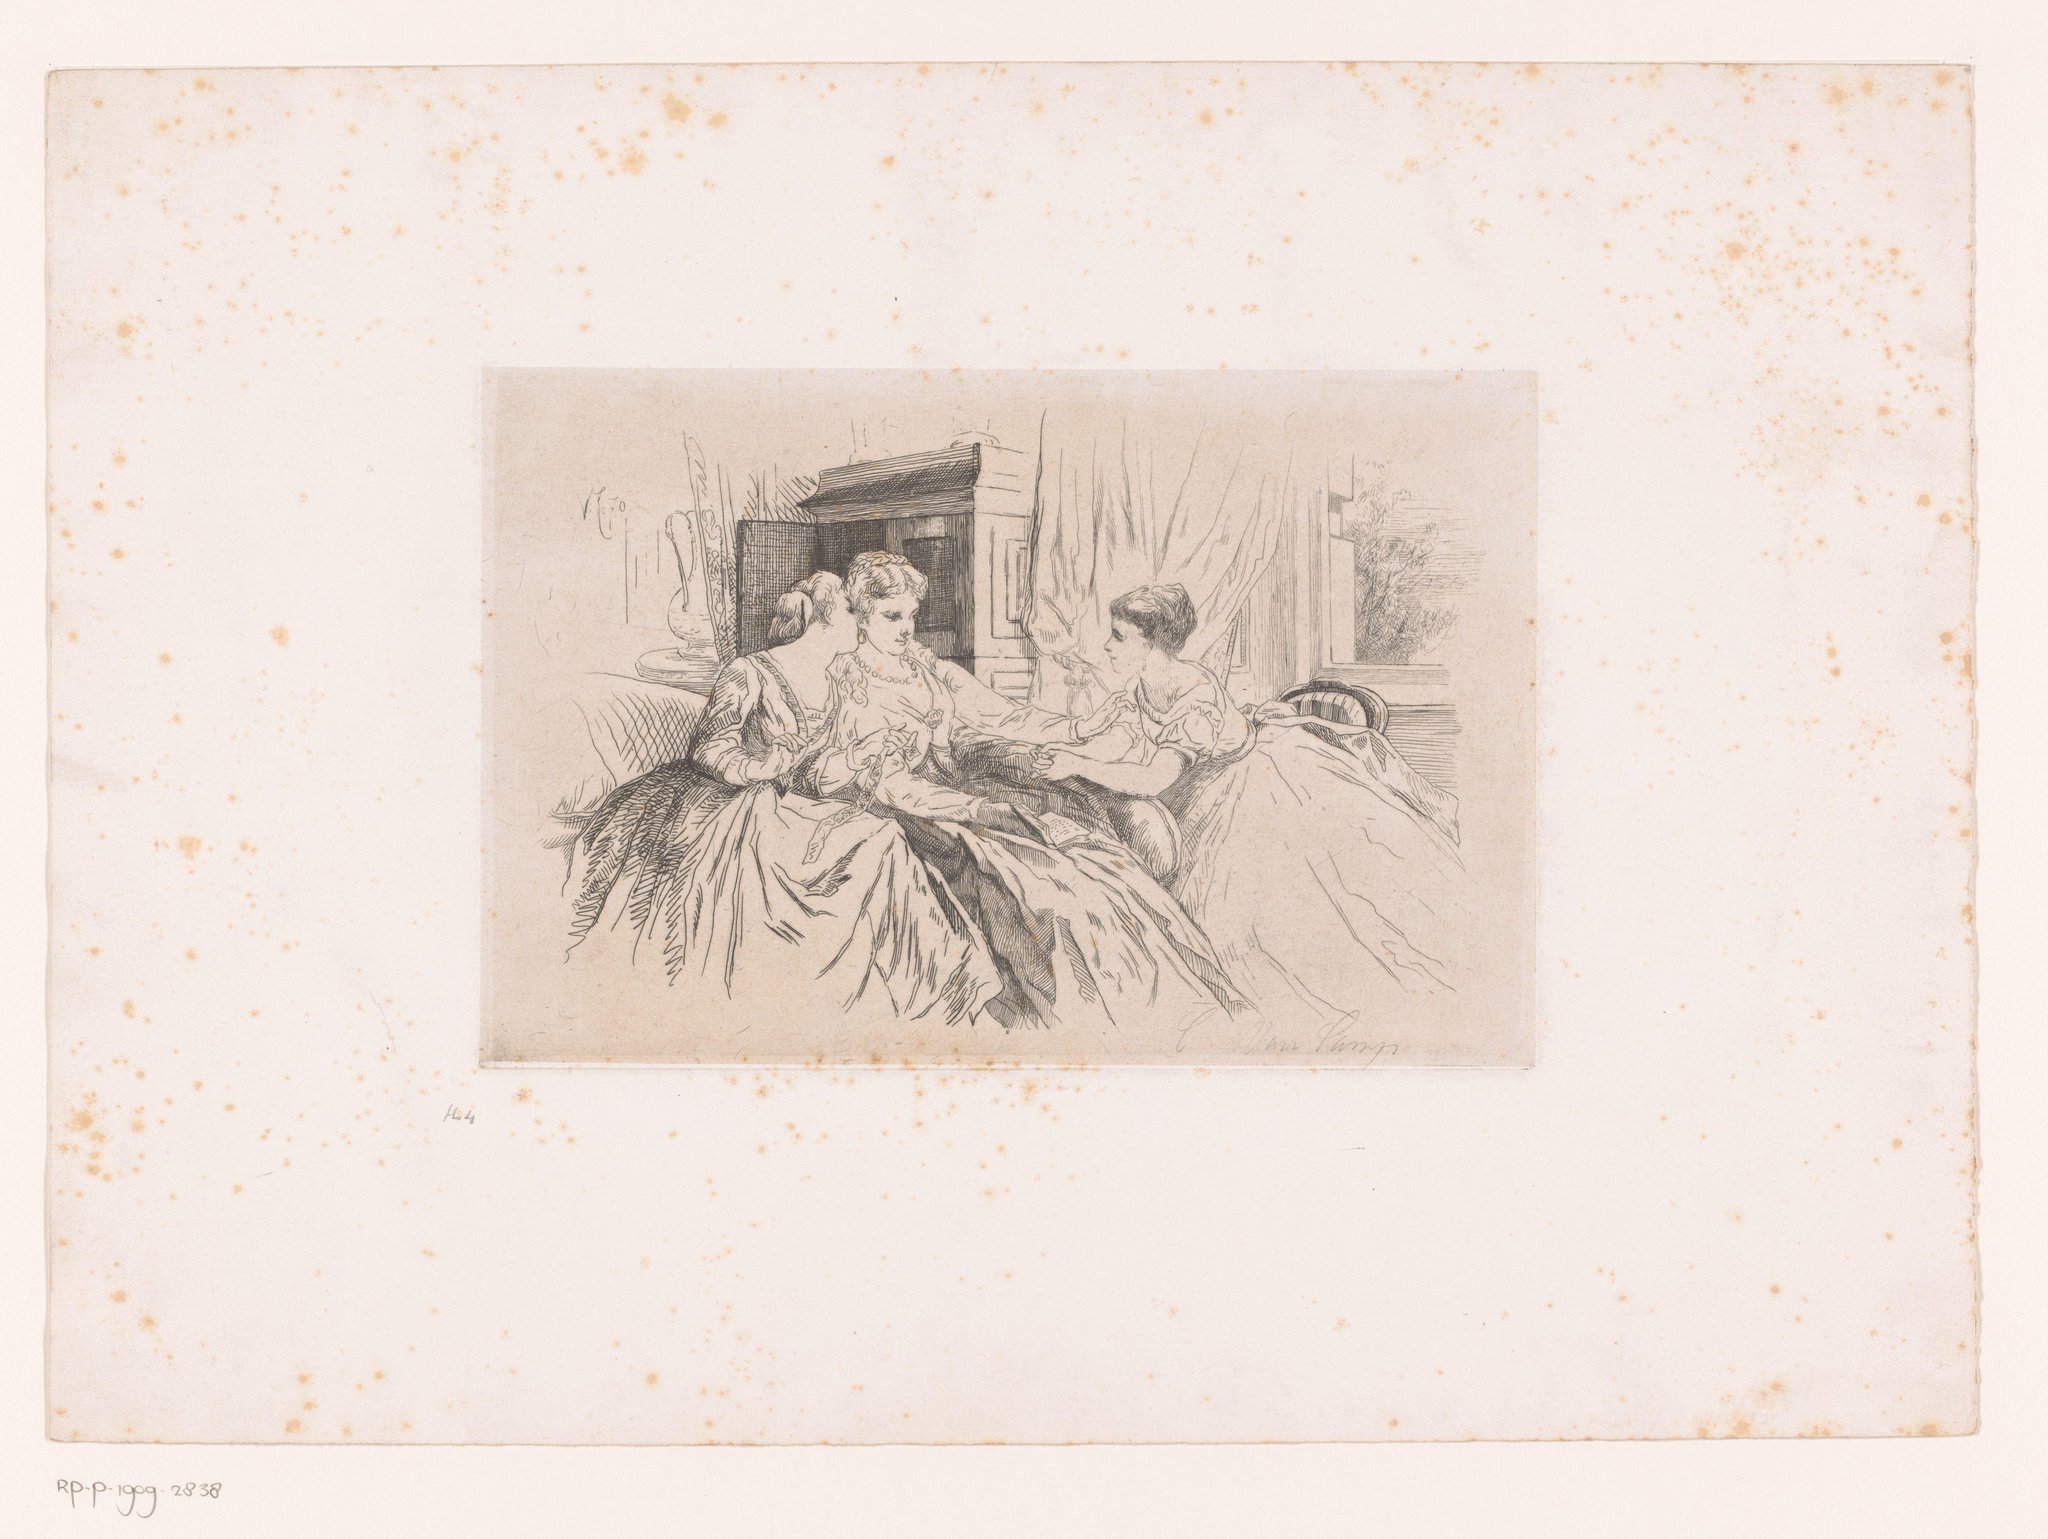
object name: print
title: Drie jonge dames in gesprek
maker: camille van camp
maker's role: print maker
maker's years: 1834-1891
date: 1870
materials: paper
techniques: etching, intaglio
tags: conversation, dialogue; conversation piece, friends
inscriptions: collector's mark: Lugt 2228